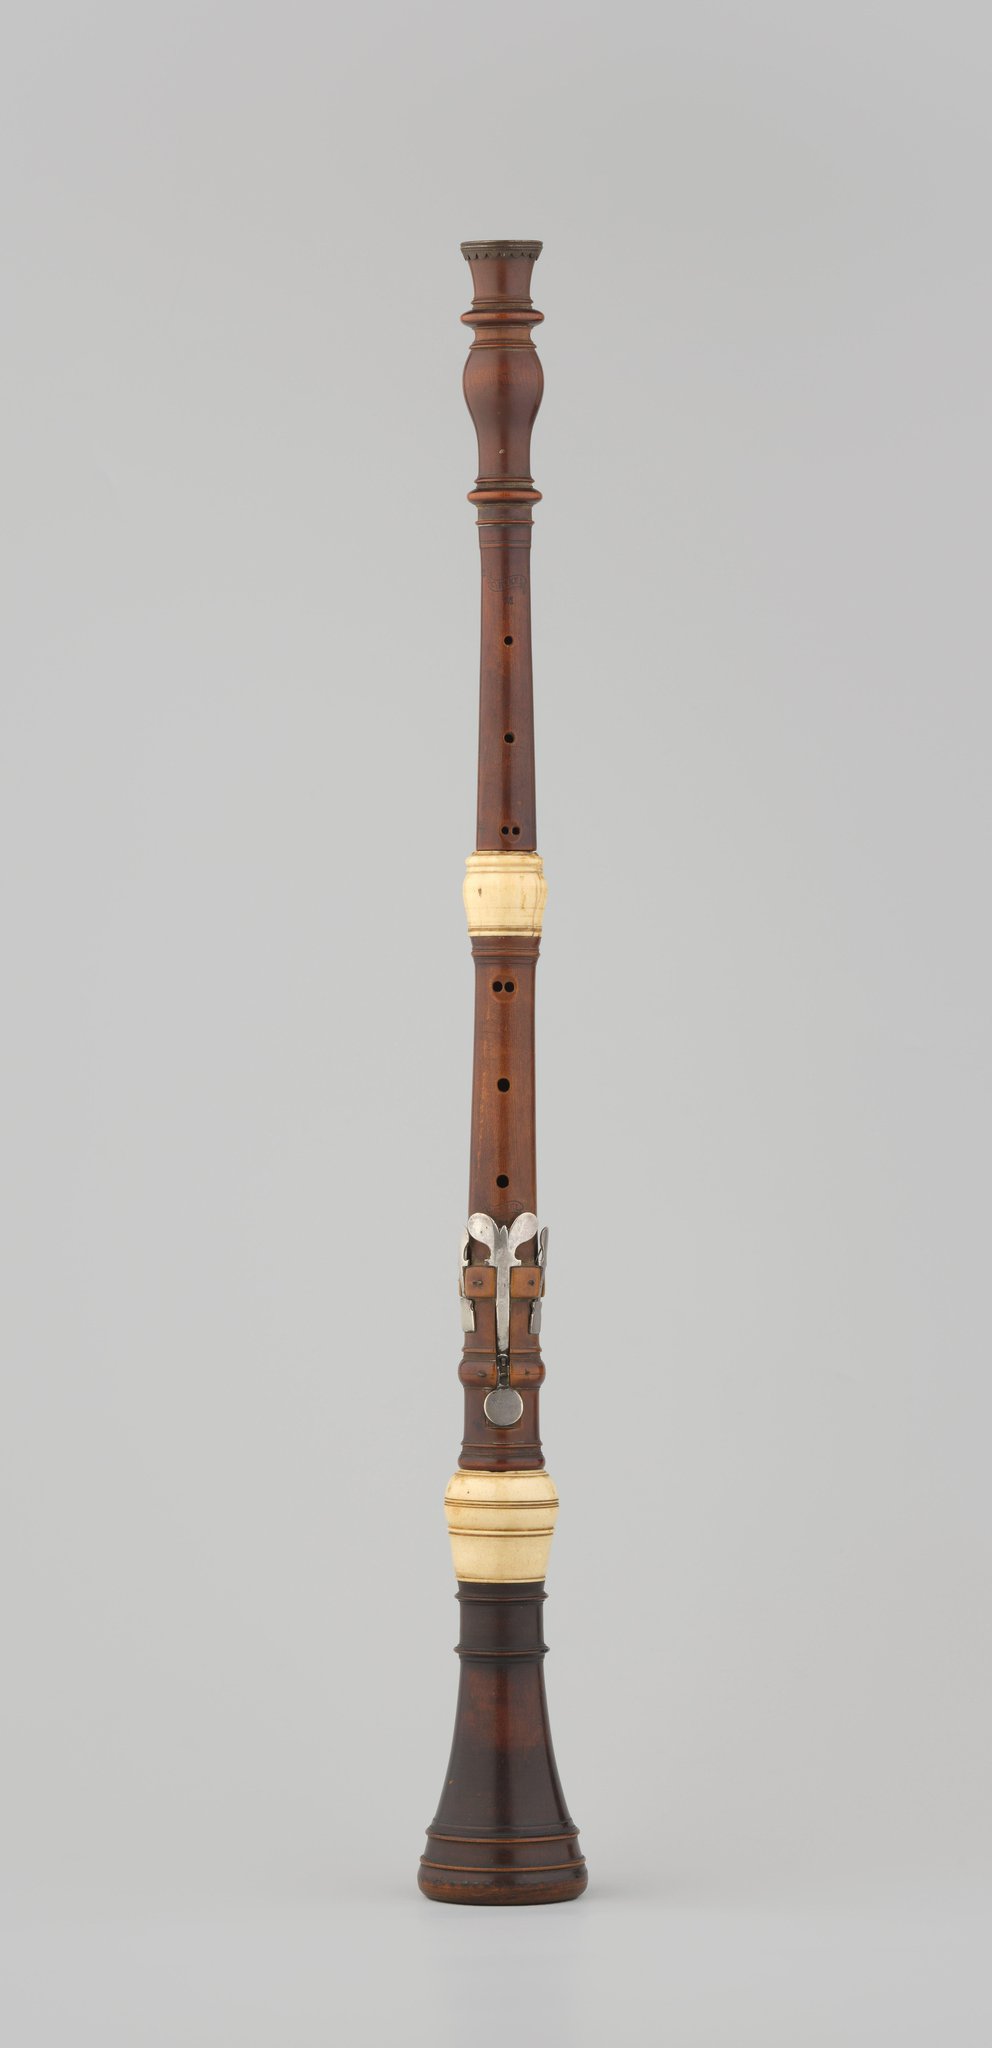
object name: musical instrument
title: Oboe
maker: coenraad rijkel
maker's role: musical instrument maker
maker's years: 1664-1726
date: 1690-1700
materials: bone, wood, silver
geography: amsterdam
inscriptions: inscription: ‘C.RIJKEL [in banderol] / [fleur de lis]’, inscription: ‘[twee fleur de lis] /C. RIJKEL [in banderol] / [fleur de lis]’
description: Six Dutch Baroque Oboes. By the late 17th century, there was a thriving woodwind industry in the Dutch Republic. Sheet music printing was also an important source of income. Over 500 oboe solos appeared in Amsterdam between c. 1690 and c. 1750. Oboes were made of hardwoods – like boxwood, ebony, fruitwoods – and ivory. The keys were made of brass or, for fancier instruments, of silver. The most lavish instruments in this gallery were produced by the Richters brothers in Amsterdam.